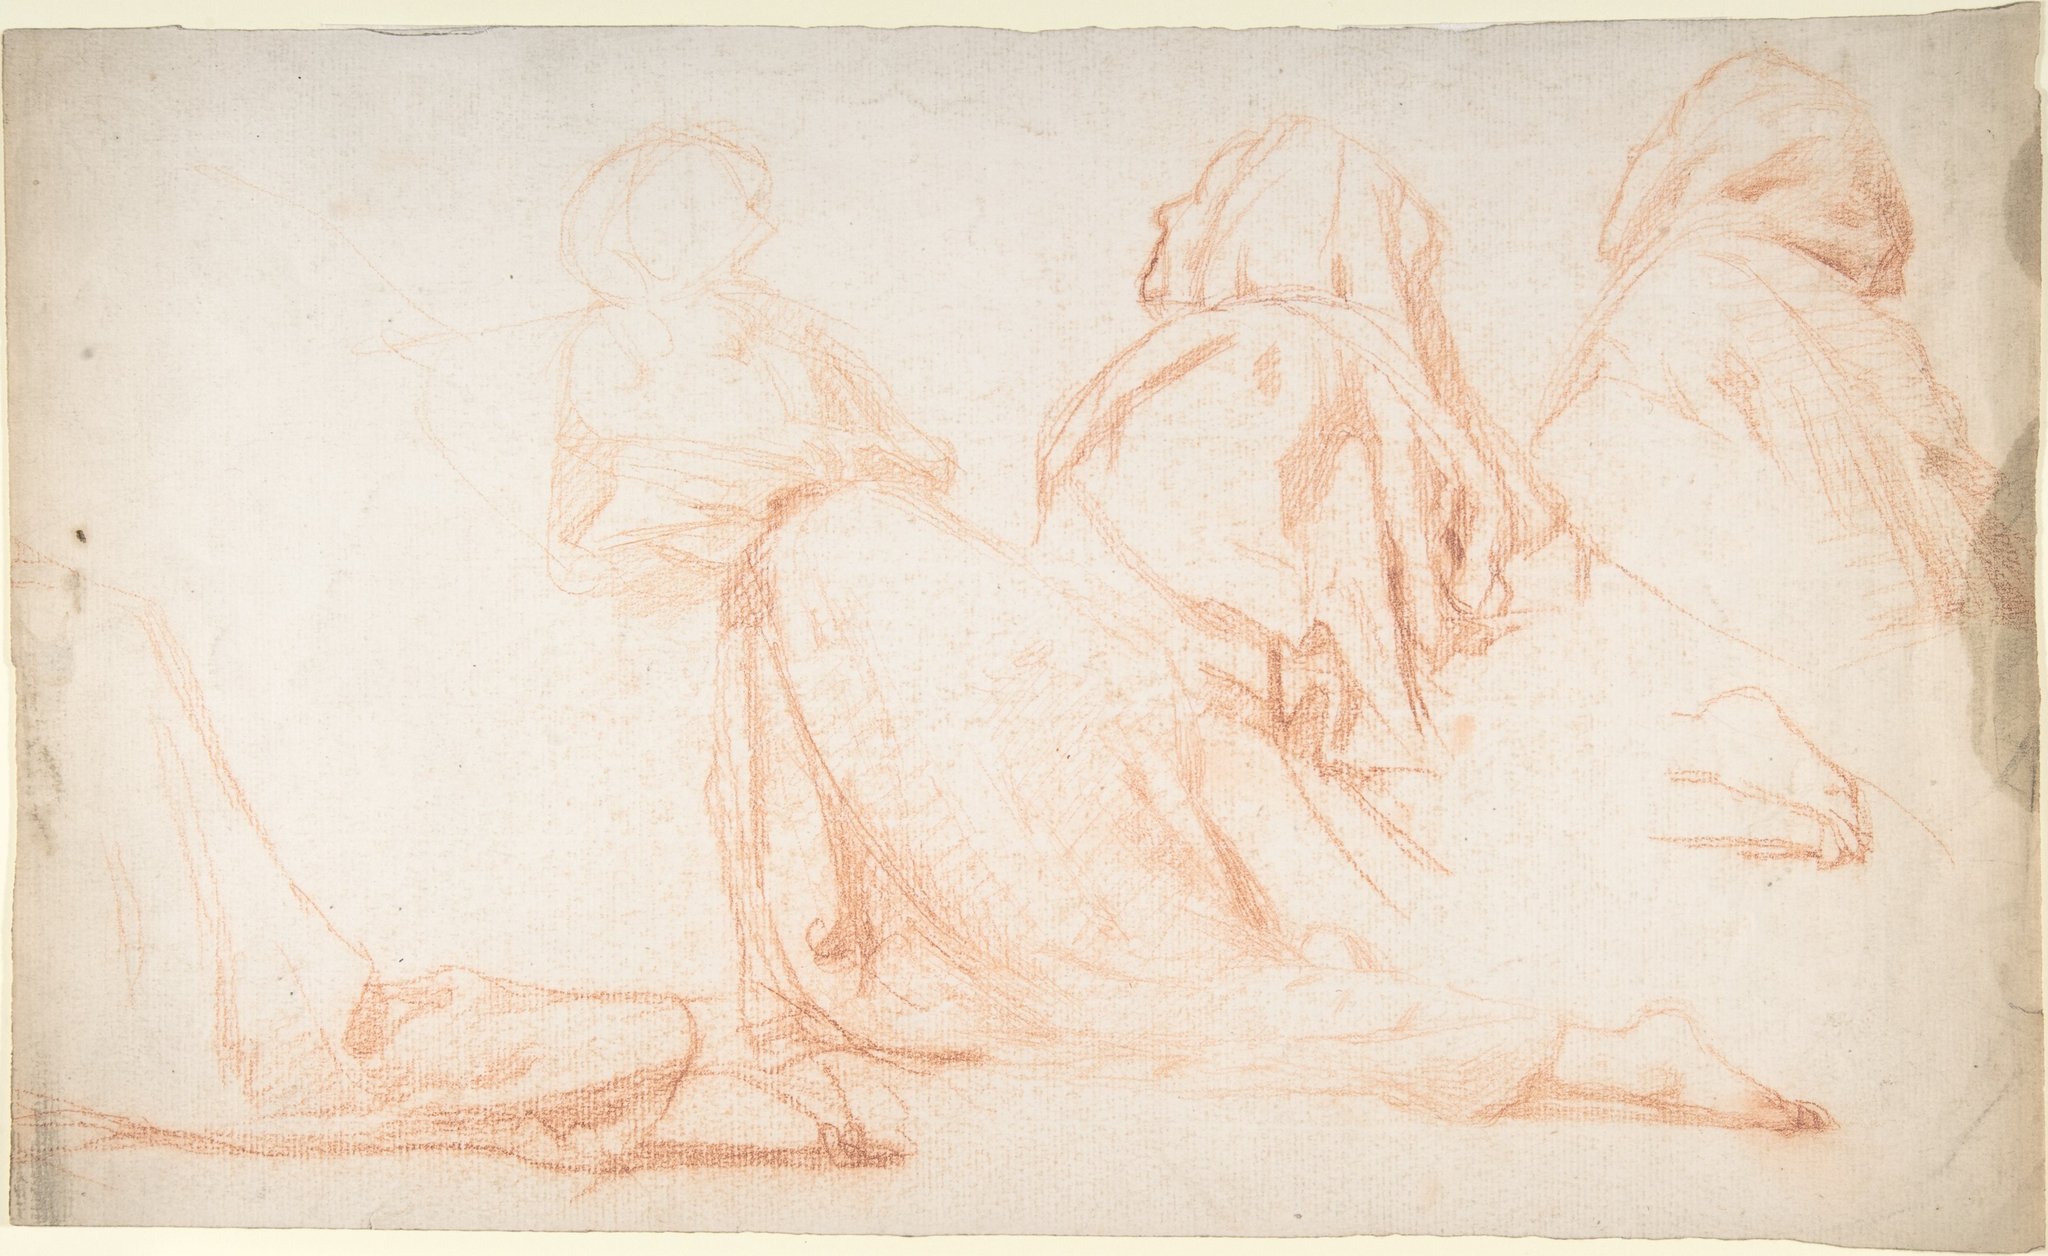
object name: drawing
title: Four Figures Kneeling in Supplication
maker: alexandre laemlein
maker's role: artist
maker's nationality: french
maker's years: 1813-1871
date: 1830-1871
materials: chalk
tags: human figures